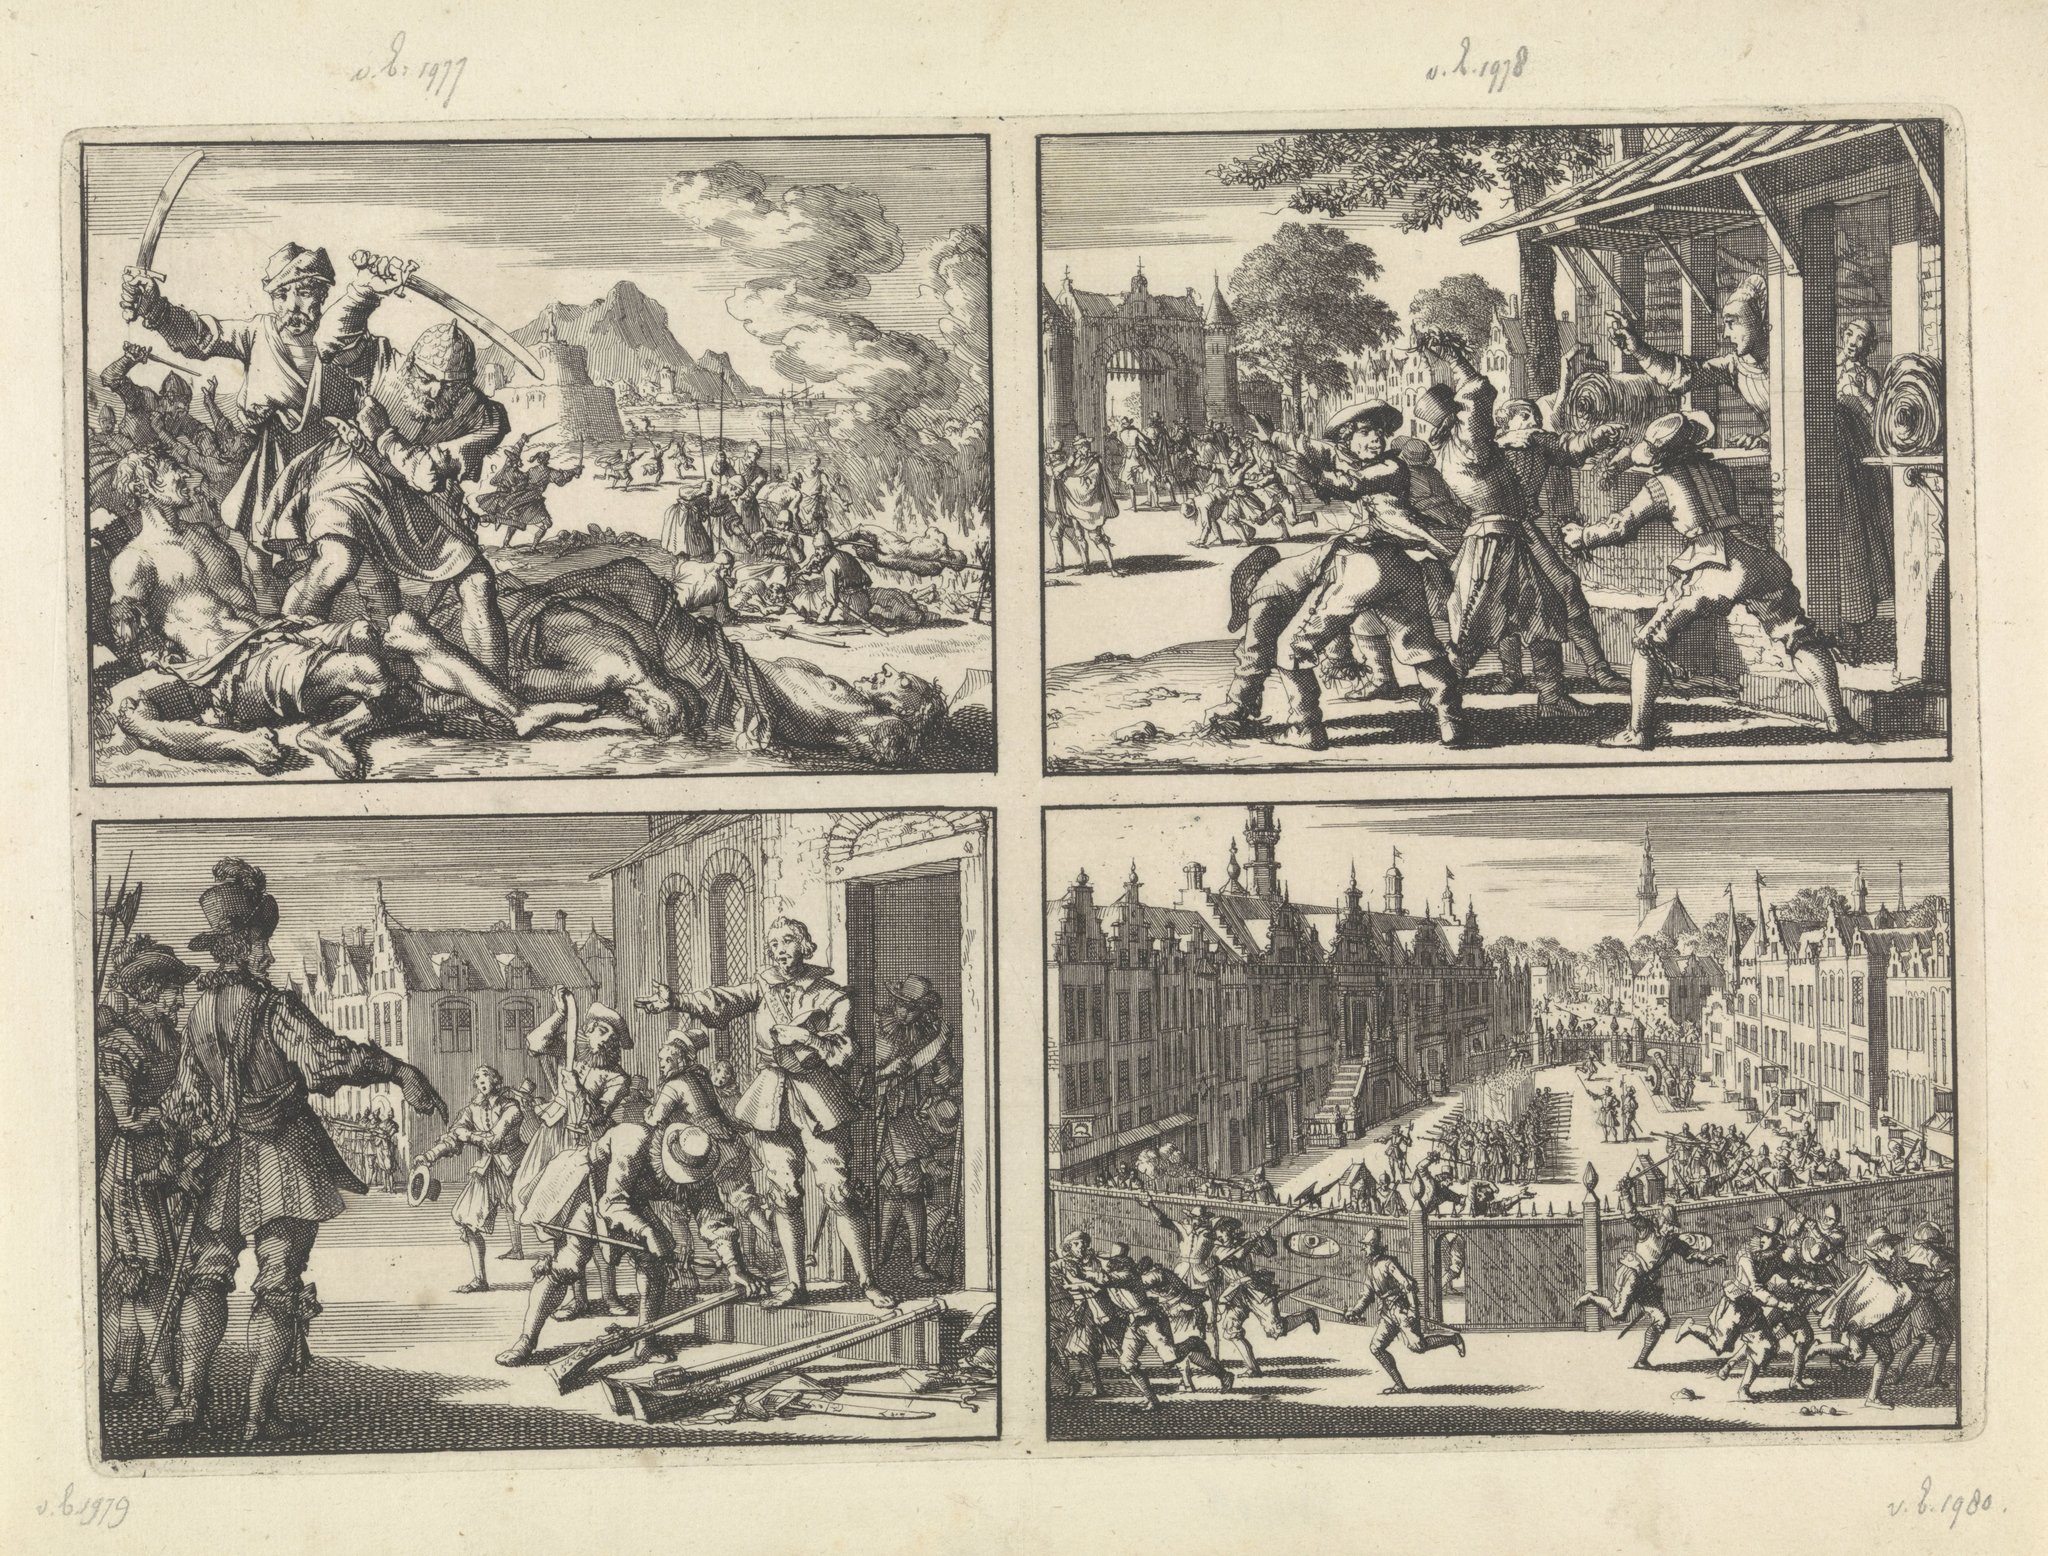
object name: print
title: Turkse wreedheden in het gebied rond Venetië, 1614 / Huizen van contraremonstranten te Schoonhoven worden aangevallen en met vuil besmeurd, 1617 / Prins Maurits op de Neude te Utrecht beveelt de Waardgelders hun wapens neer te leggen, 1618 / Breestraat te Leiden door Waardgelders bezet, 1618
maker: jan luyken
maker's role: draughtsman, print maker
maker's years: 1649-1712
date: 1698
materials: paper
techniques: etching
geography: amsterdam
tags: maurice (prince of orange), capture of city (after the siege) (+ variant), ruler commanding, the soldier; the soldier's life (+ weapons), protestant churches and denominations, asiatic races and peoples: turks, battle, fighting in general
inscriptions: collector's mark: Lugt 2228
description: Prenten gebruikt als illustratie in: Gottfried, Johann Ludwig. Historische kronyck; vervattende een (...) beschrijvingh der aldergedenckwaerdigste geschiedenissen des weerelds, van den aenvangh der scheppingh tot (...) 1576 (2 delen). Leiden: Pieter van der Aa, 1698, dl. I, p. 775, 817, 825, 857.